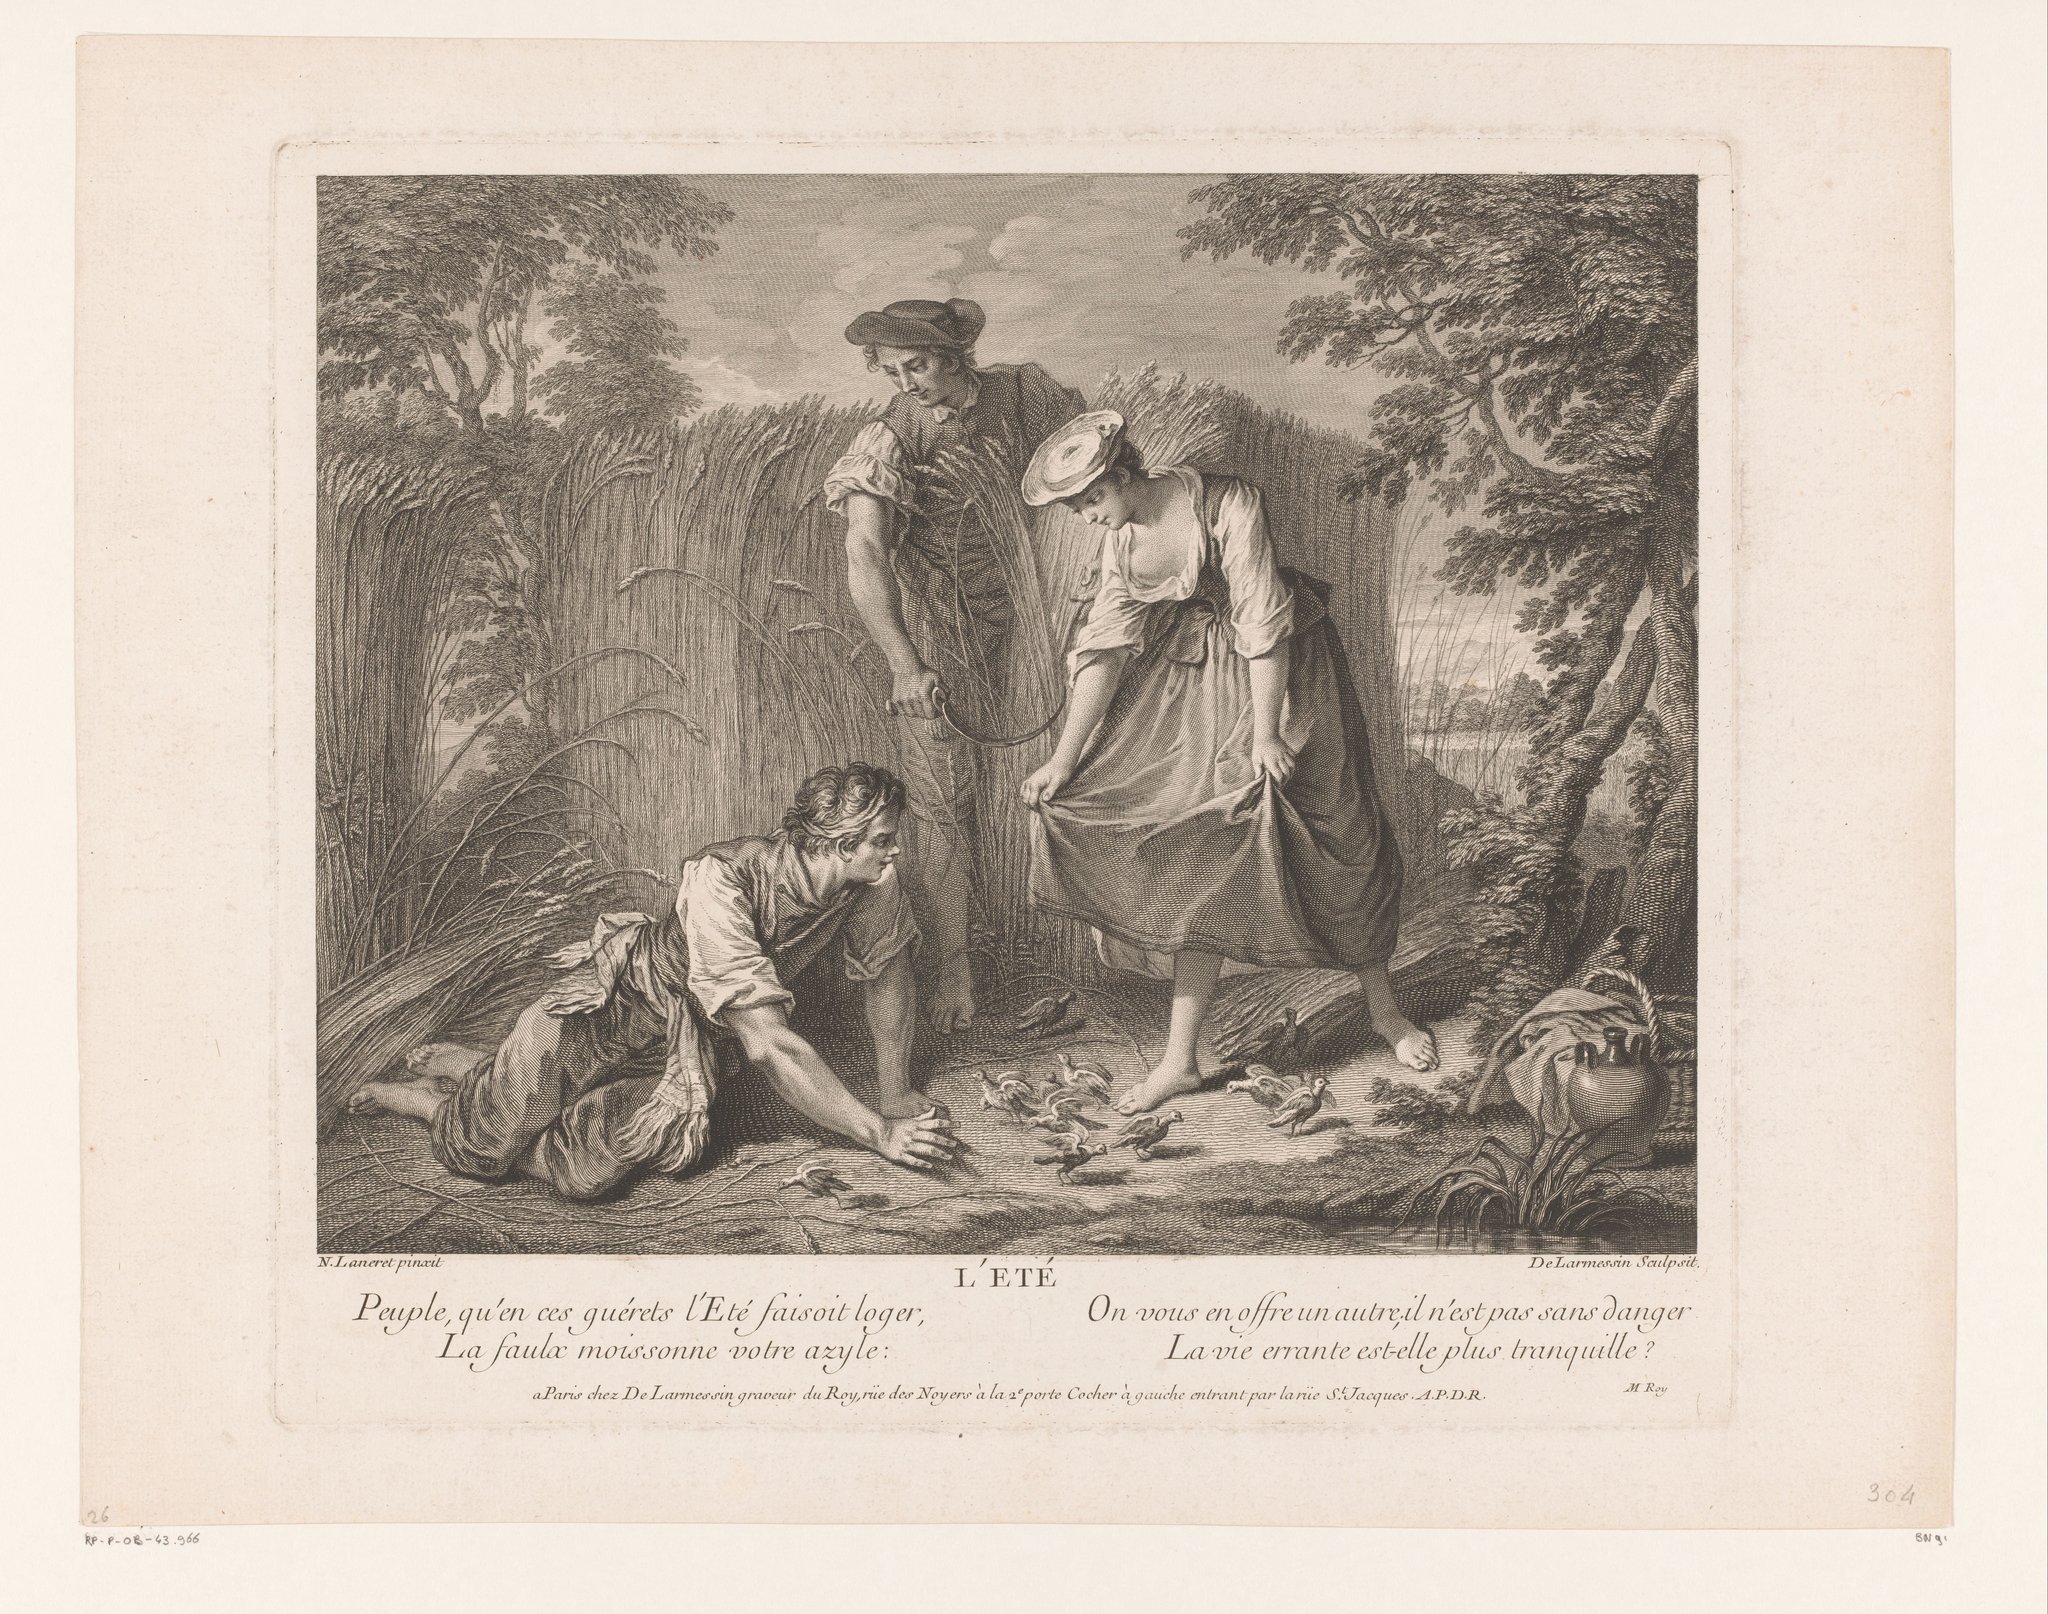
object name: print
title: Les Quatre Saisons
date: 1745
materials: paper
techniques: engraving, etching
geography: france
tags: harvest, summer ~ human activities (the four seasons of the year), fowl (cock, hen, chicken, etc.)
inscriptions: collector's mark: Lugt 240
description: Oogstende figuren met twee mannen en een vrouw die een groep kuikens het veld uitjagen en hen proberen te vangen.